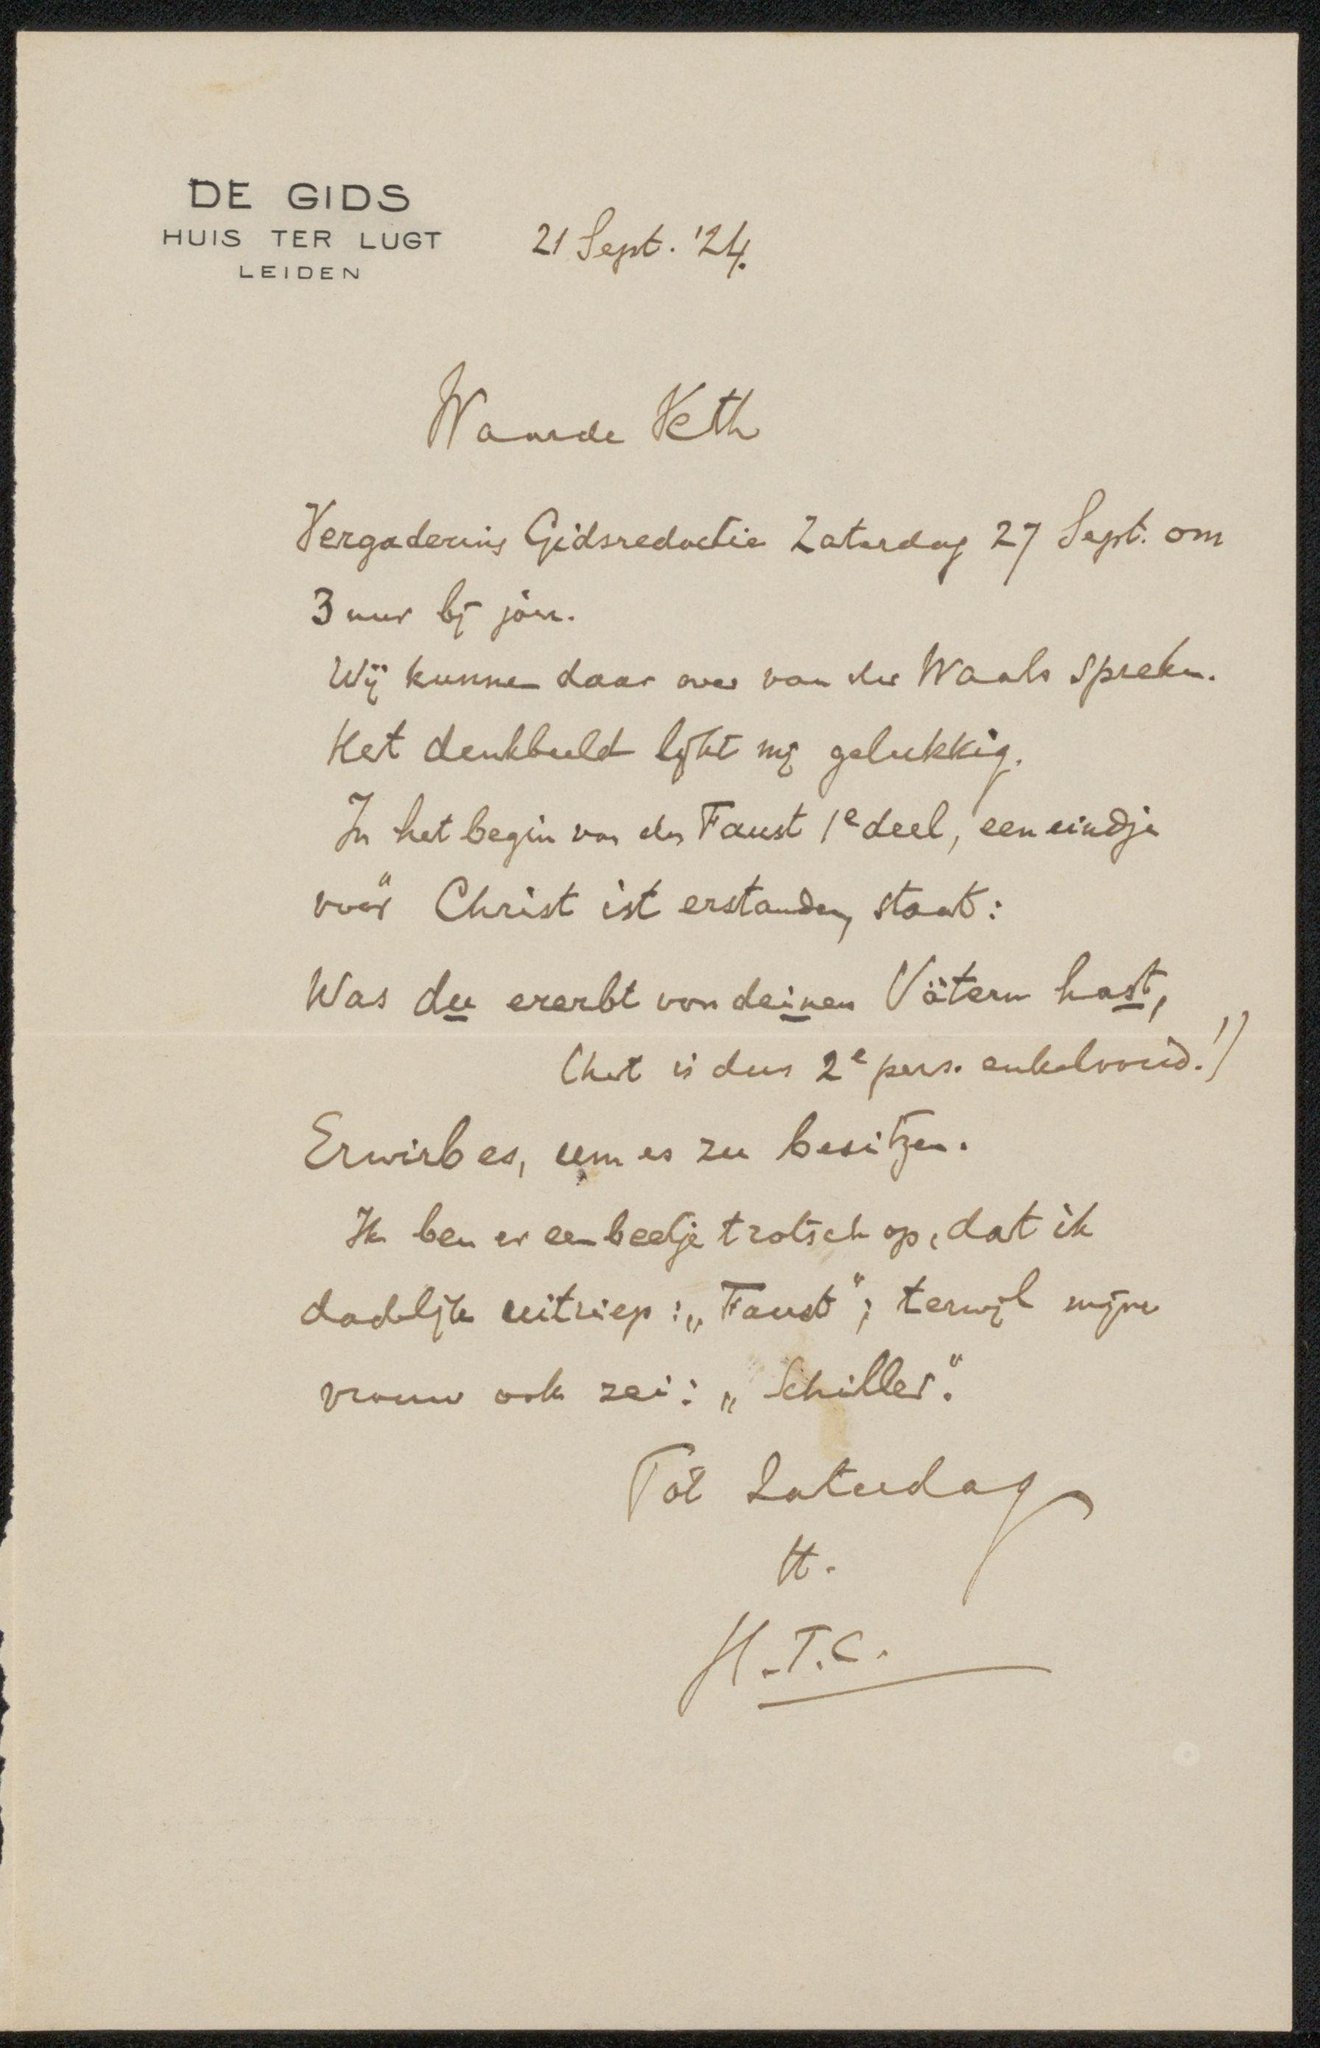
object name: letter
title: Brief aan Jan Veth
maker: herman theodoor colenbrander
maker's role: historicus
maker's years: 1871-1945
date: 1924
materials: ink, paper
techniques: pen, printing, writing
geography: leiden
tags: dordrecht, painter, designer, jan veth, draughtsman, johann wolfgang von goethe, leiden, amsterdam, physicist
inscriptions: collector's mark: ‘RPK’